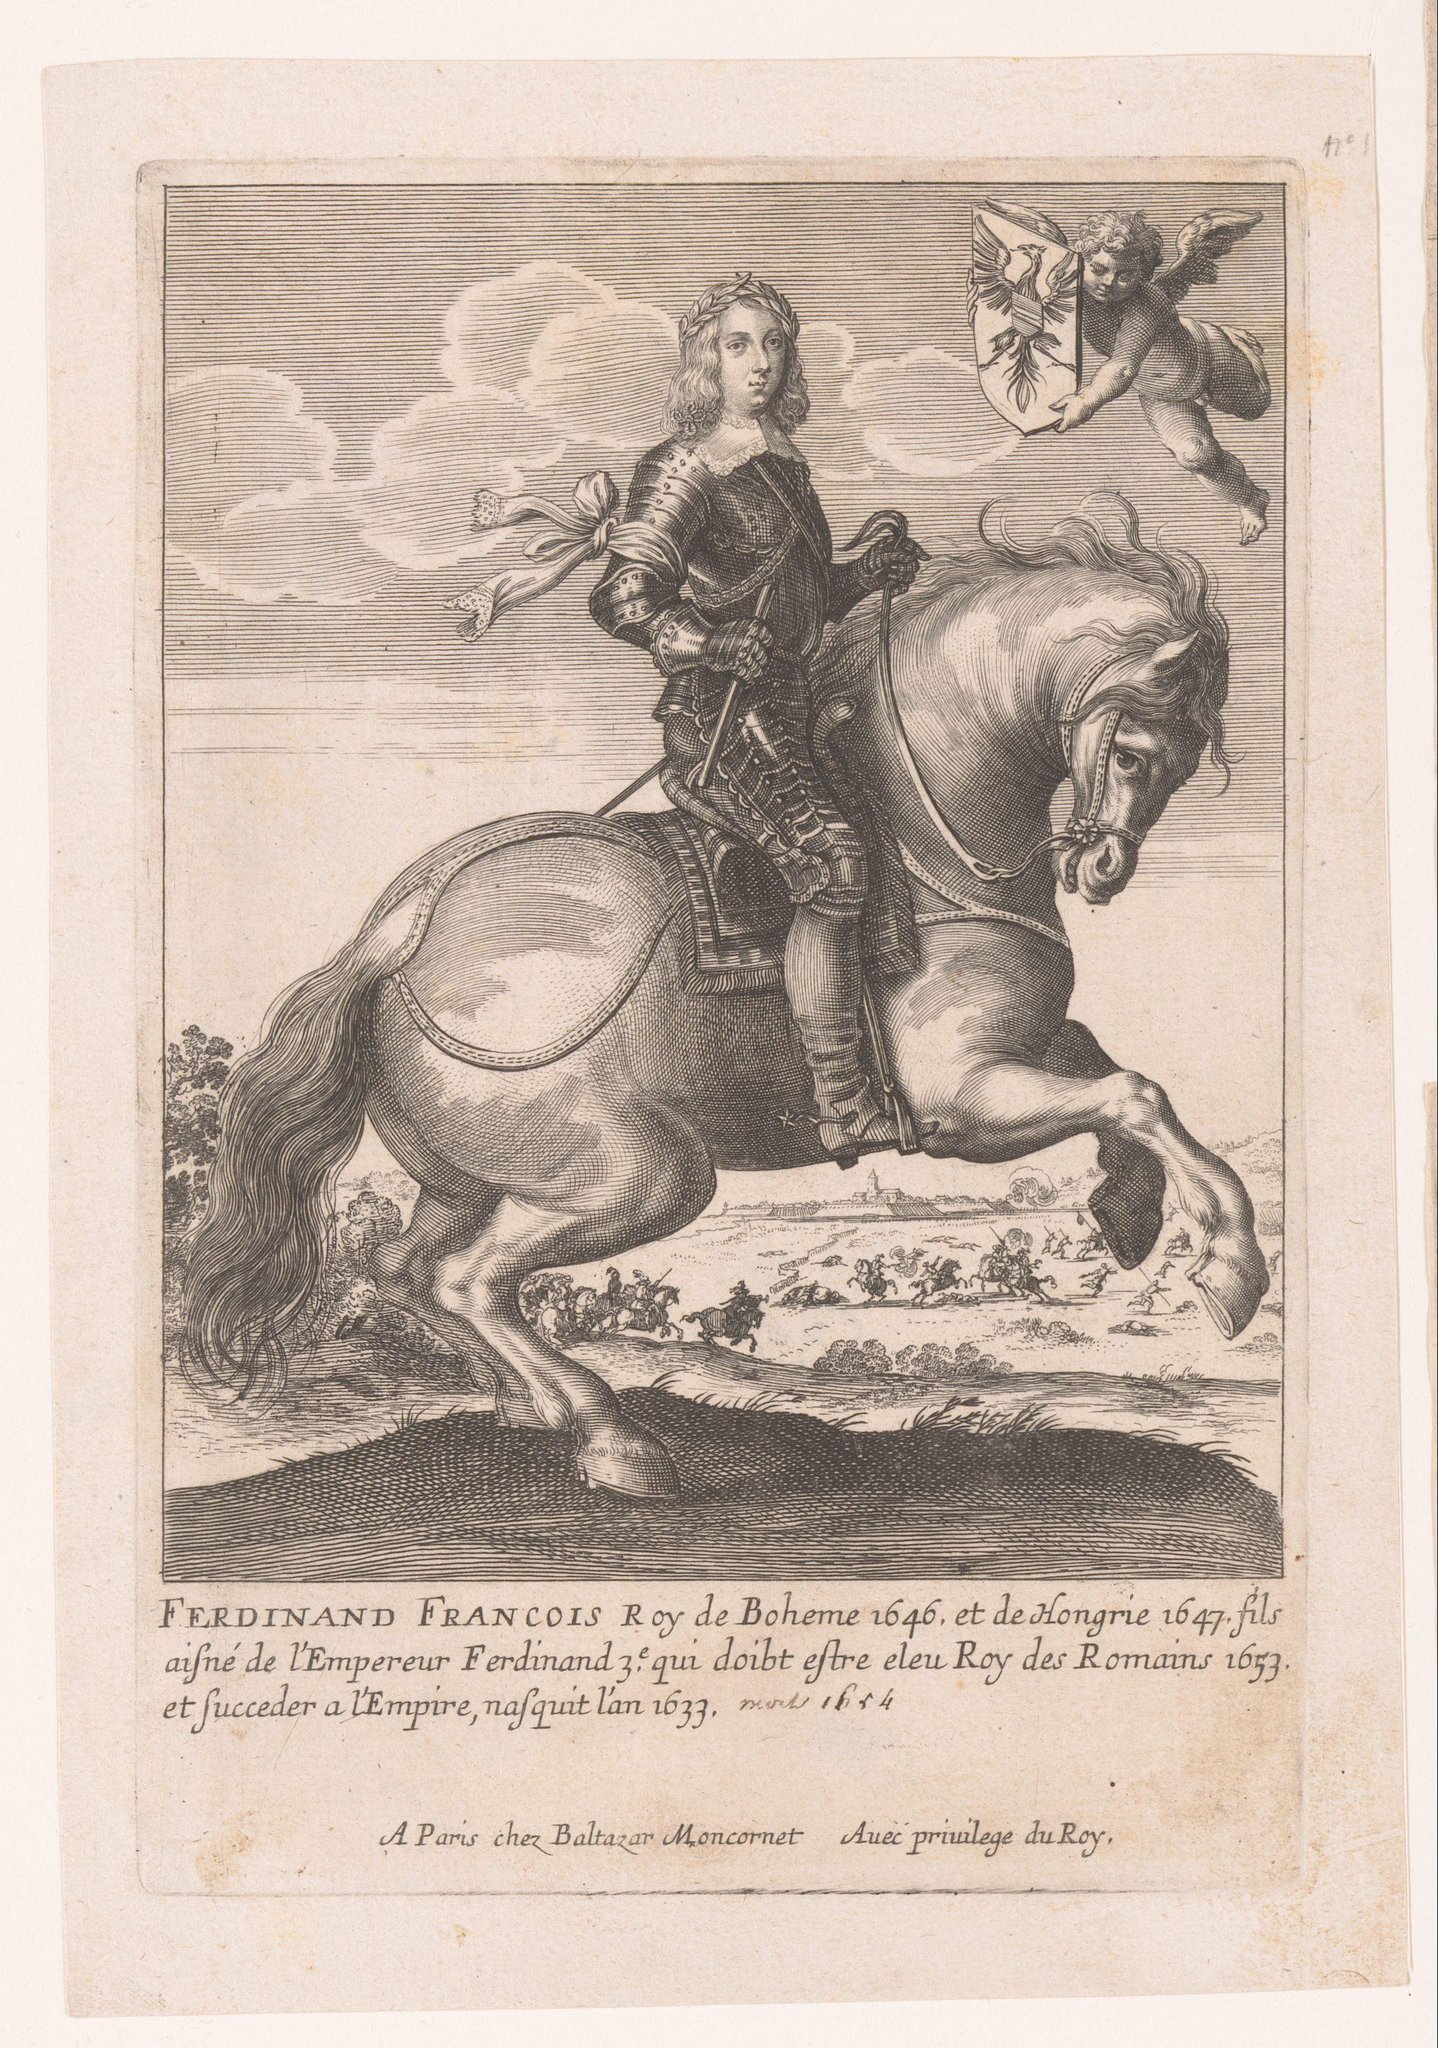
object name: print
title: Portret van Ferdinand IV van Hongarije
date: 1653-1668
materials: paper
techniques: engraving, etching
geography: paris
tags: vienna, historical persons, king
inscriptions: collector's mark: Lugt 2228, inscription: ‘mort 1654’